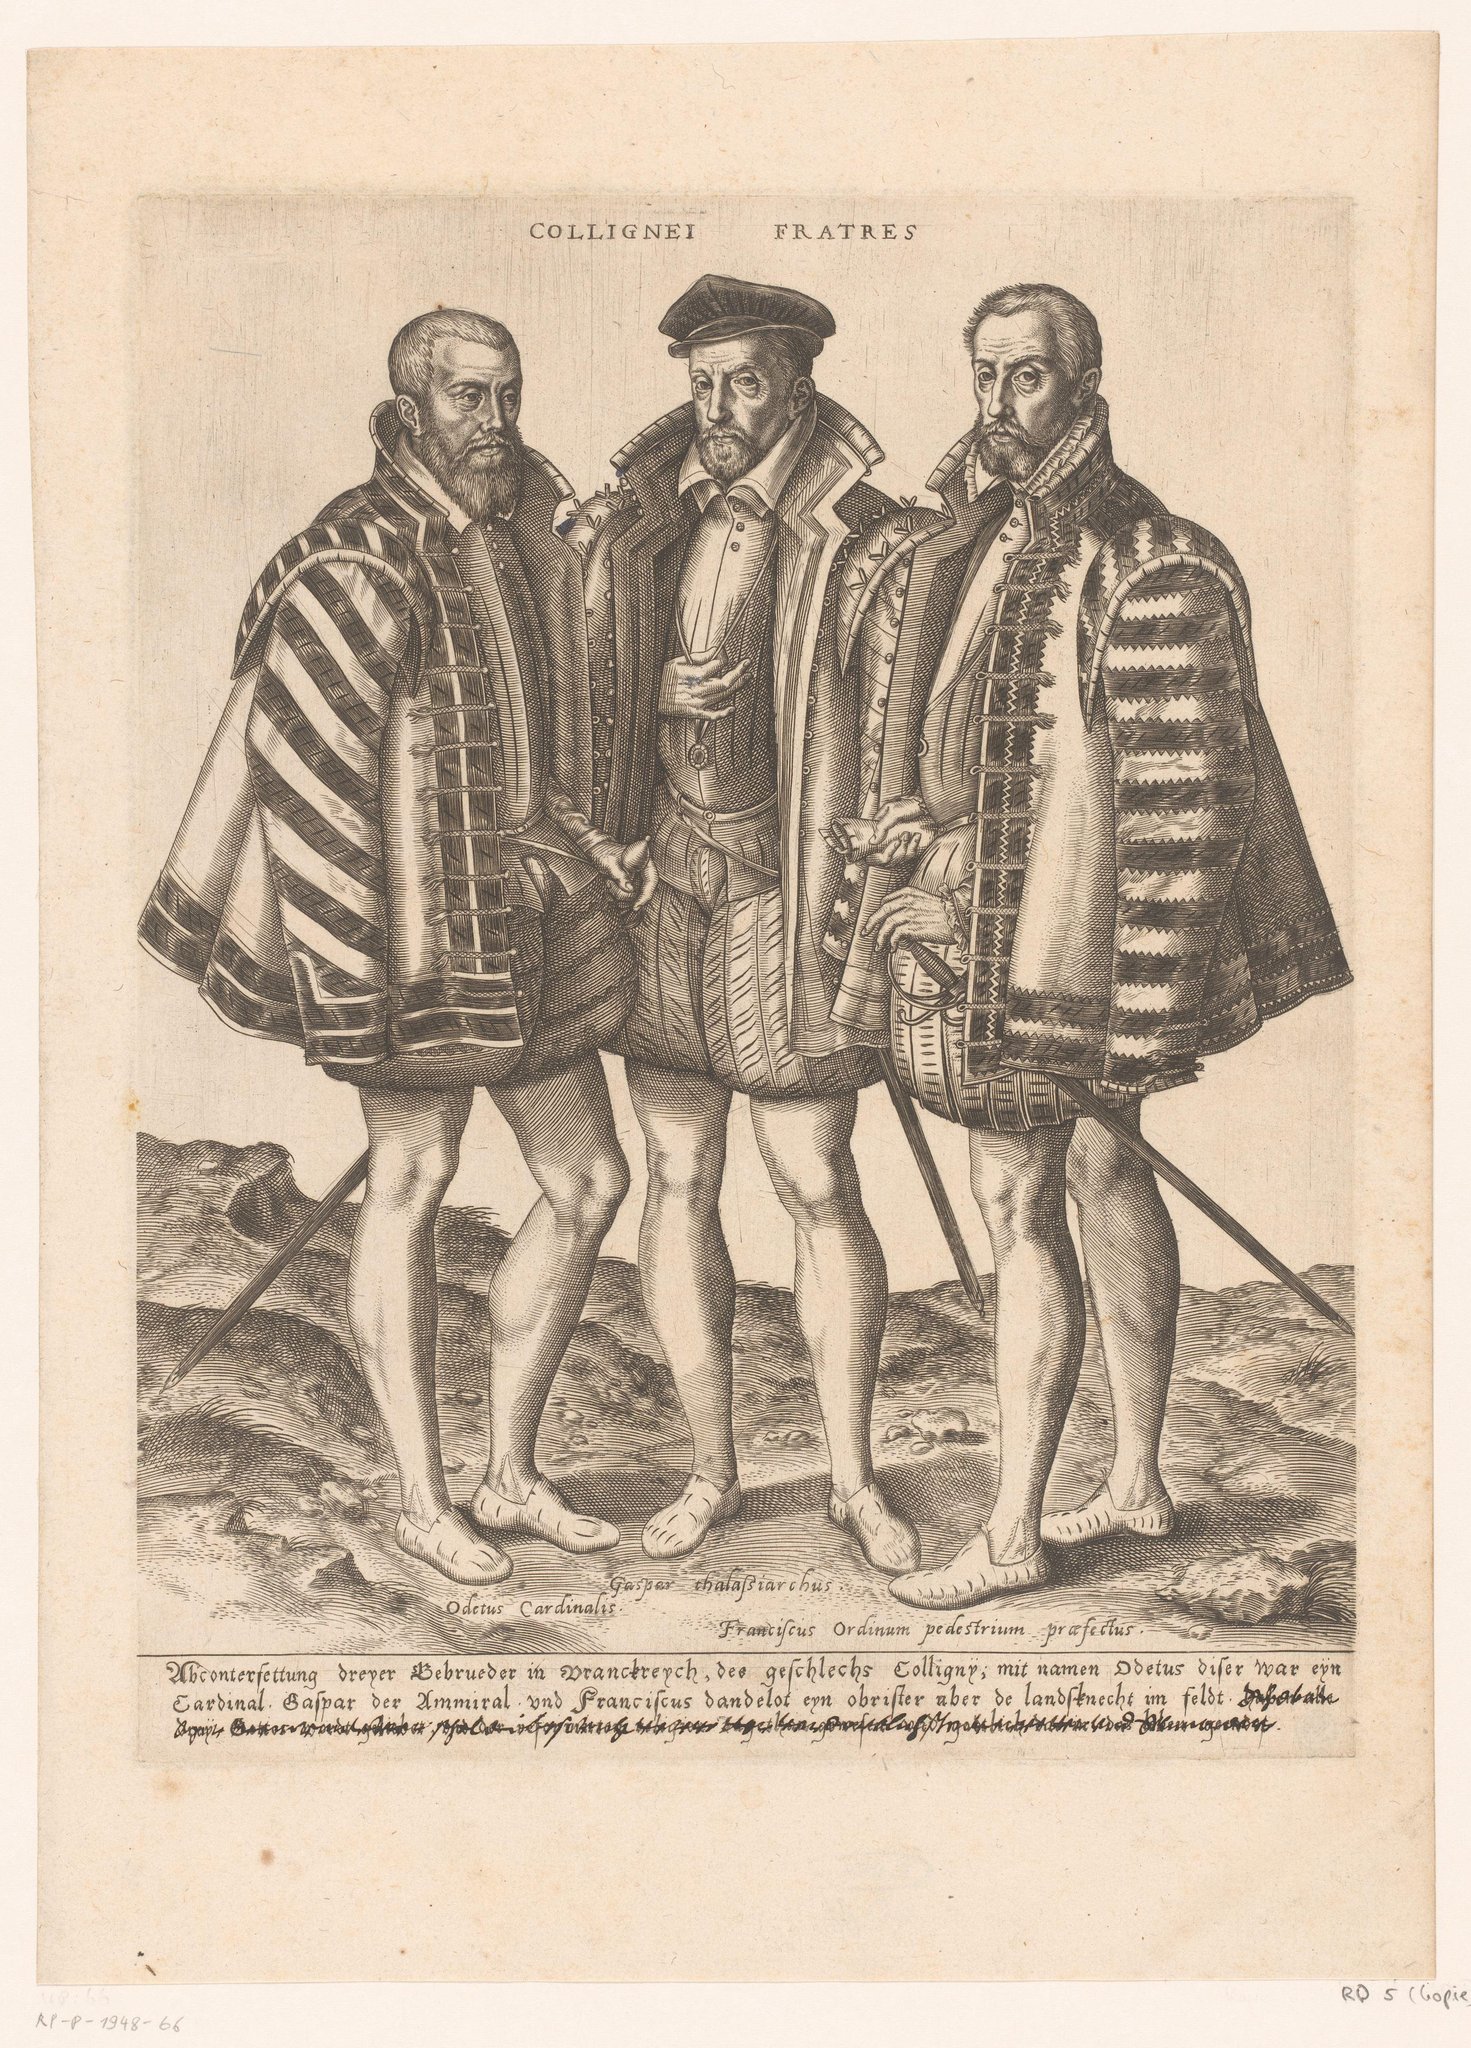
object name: print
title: Collignei fratres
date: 1579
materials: paper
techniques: engraving, intaglio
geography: france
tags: historical persons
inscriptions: inscription: ‘[...]’, collector's mark: Lugt 2228